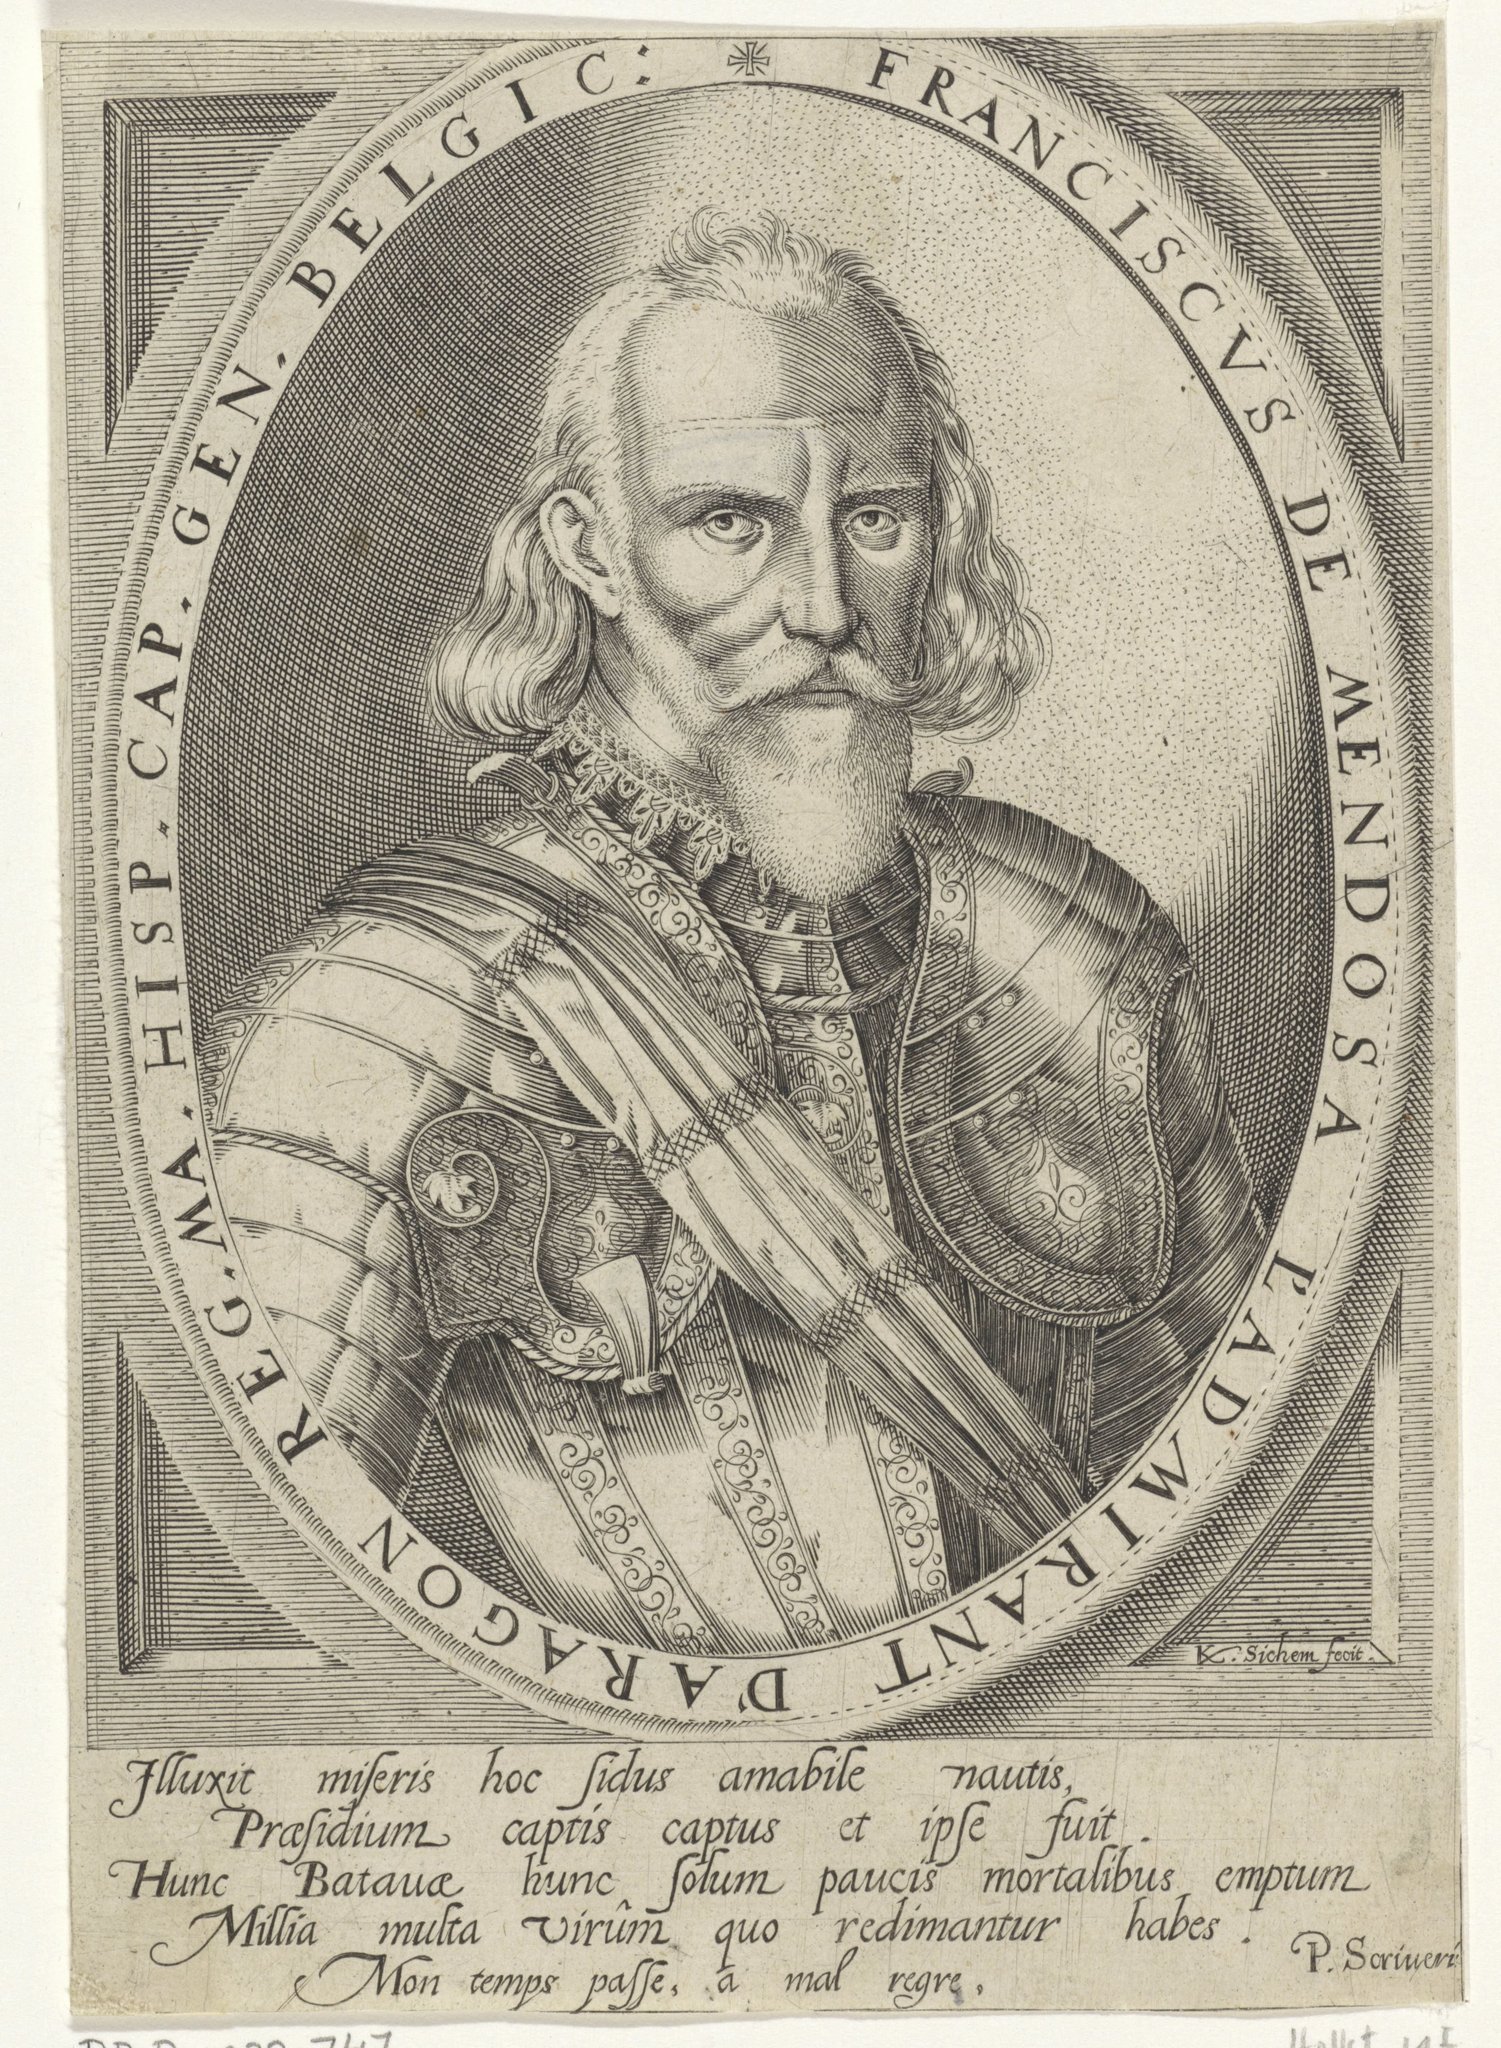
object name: print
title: Portret van Francisco Hurtado de Mendoza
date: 1585-1645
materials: paper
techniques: engraving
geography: amsterdam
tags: admiraal, francisco hurtado de mendoza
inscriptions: collector's mark: Lugt 2228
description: Portret van generaal Francisco Hurtado de Mendoza. In een ovale omlijsting staan in het Latijn zijn naam en functie. Onder het portret vier Latijnse versregels van Petrus Scriverius. Daaronder in het Frans zijn motto.